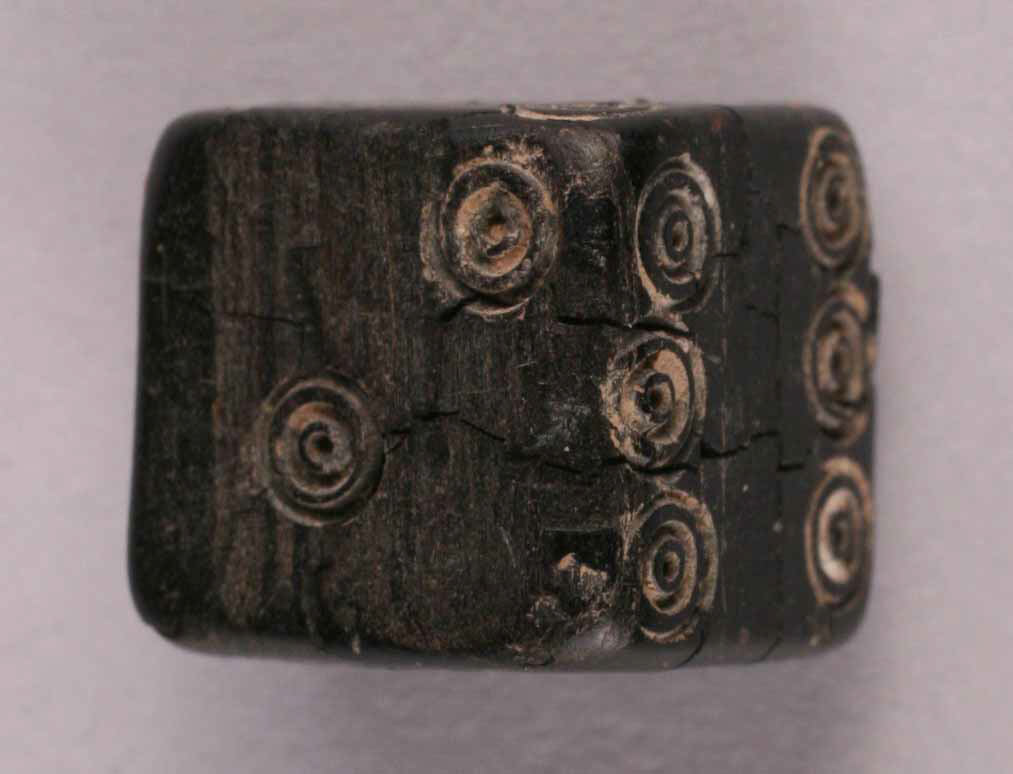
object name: dice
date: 701-1200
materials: pigment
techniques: inlay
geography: iran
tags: dice